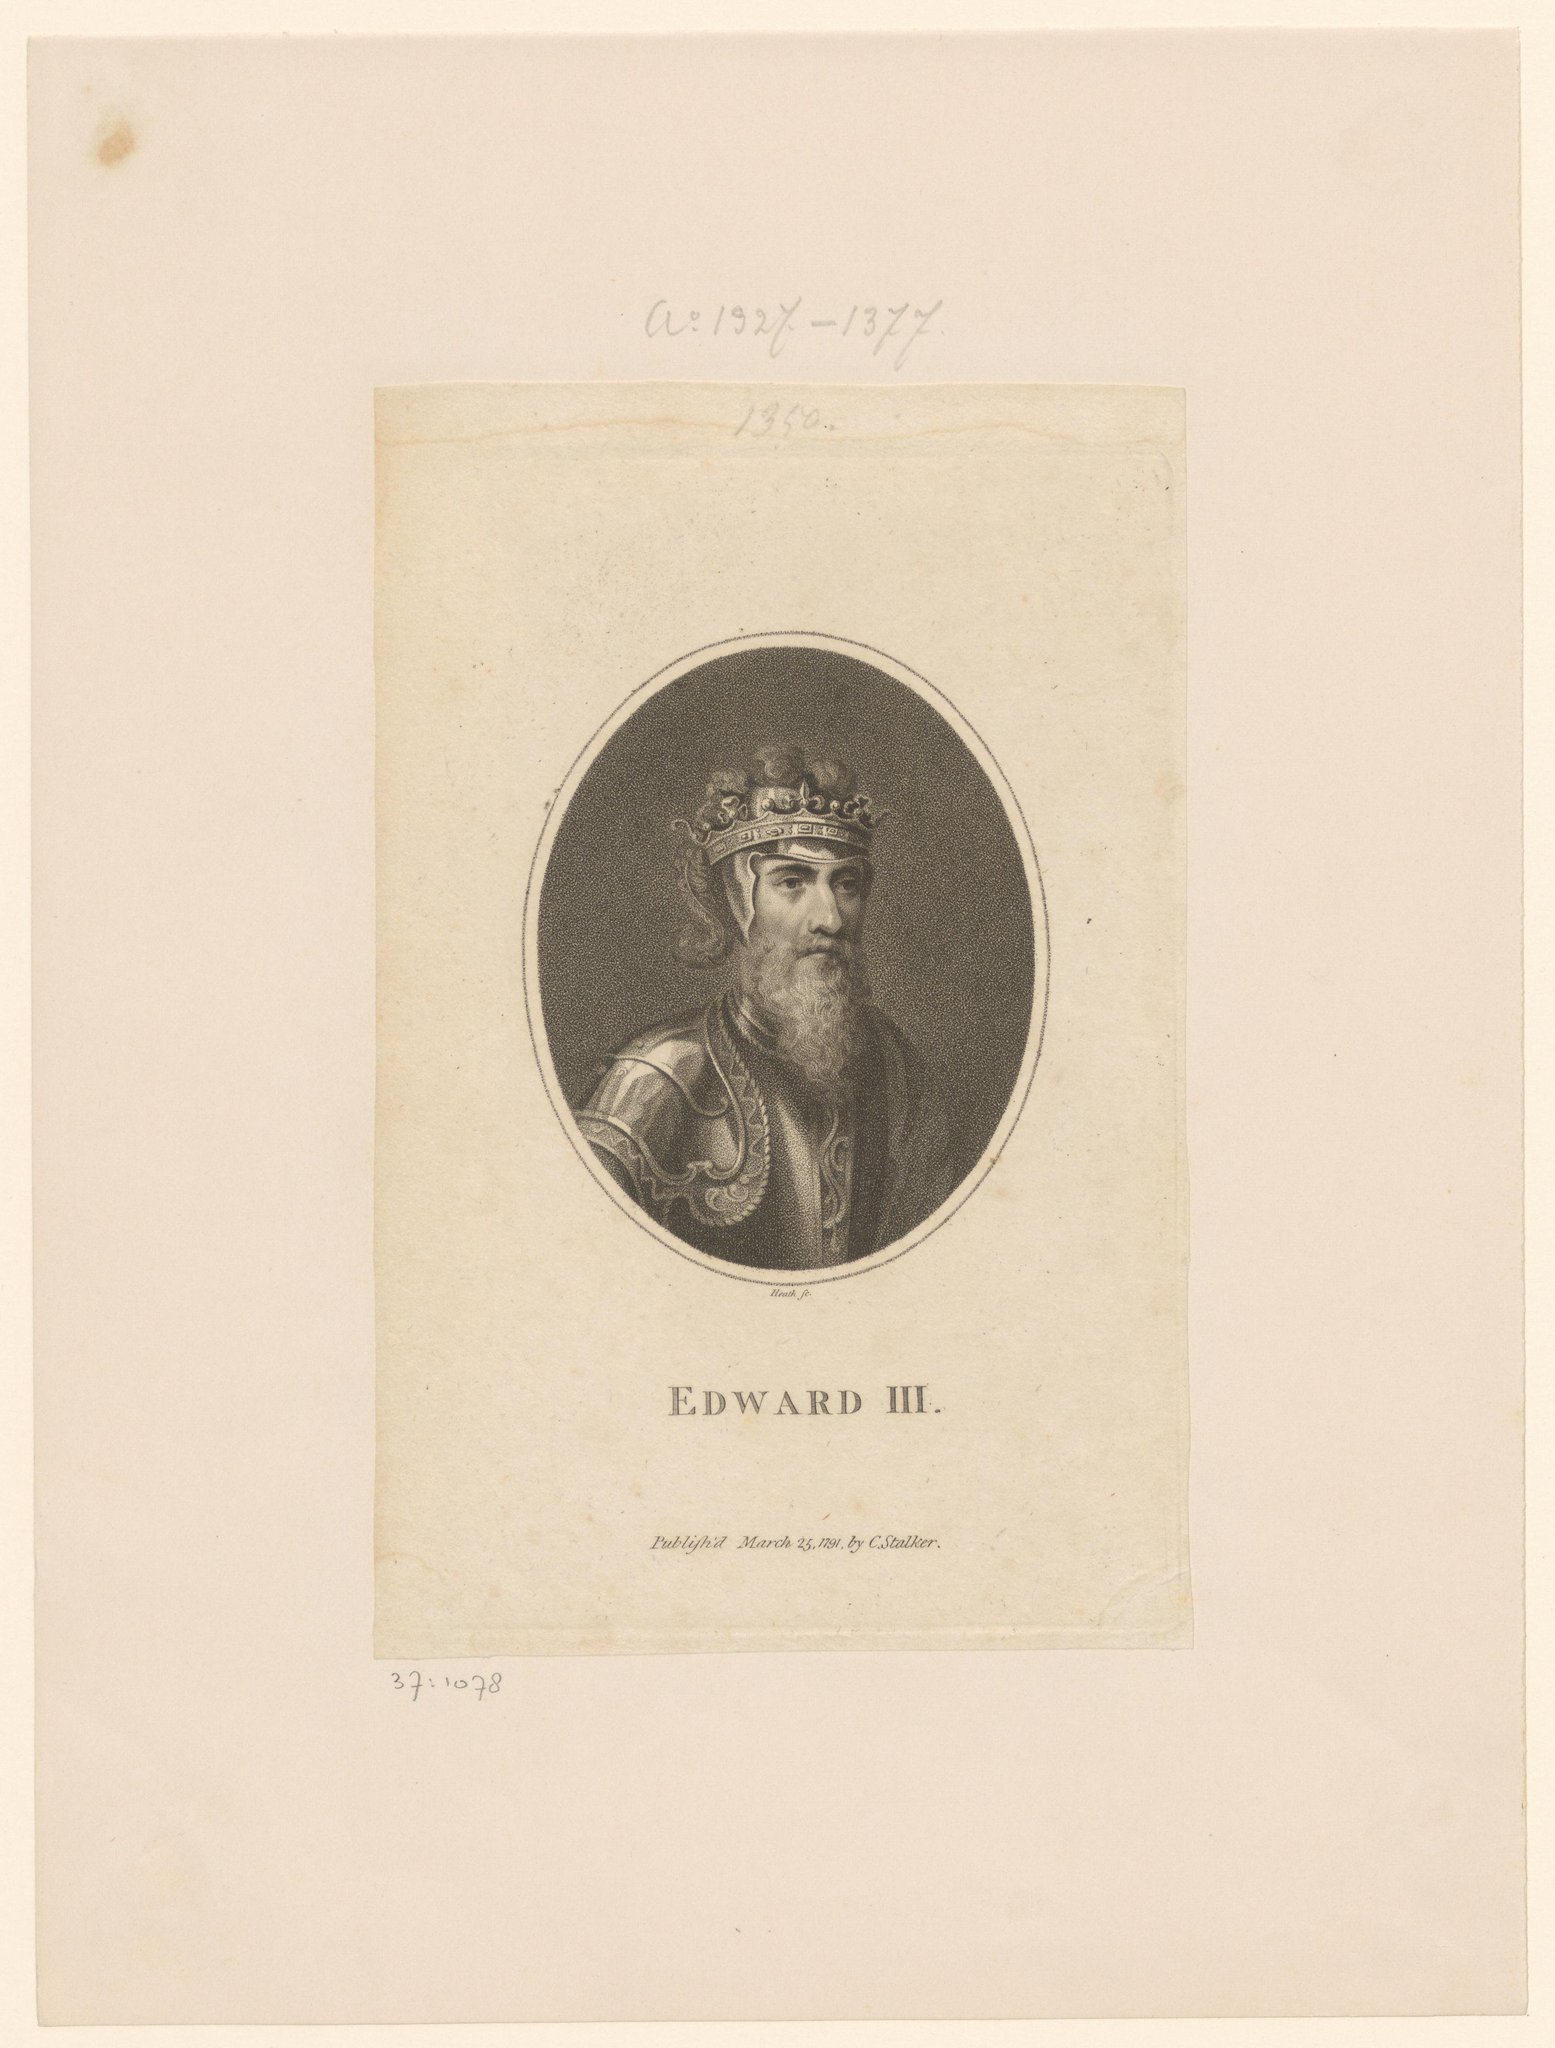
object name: print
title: Edward III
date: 1703-1791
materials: paper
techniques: stippling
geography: london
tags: historical persons, king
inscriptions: collector's mark: Lugt 2228